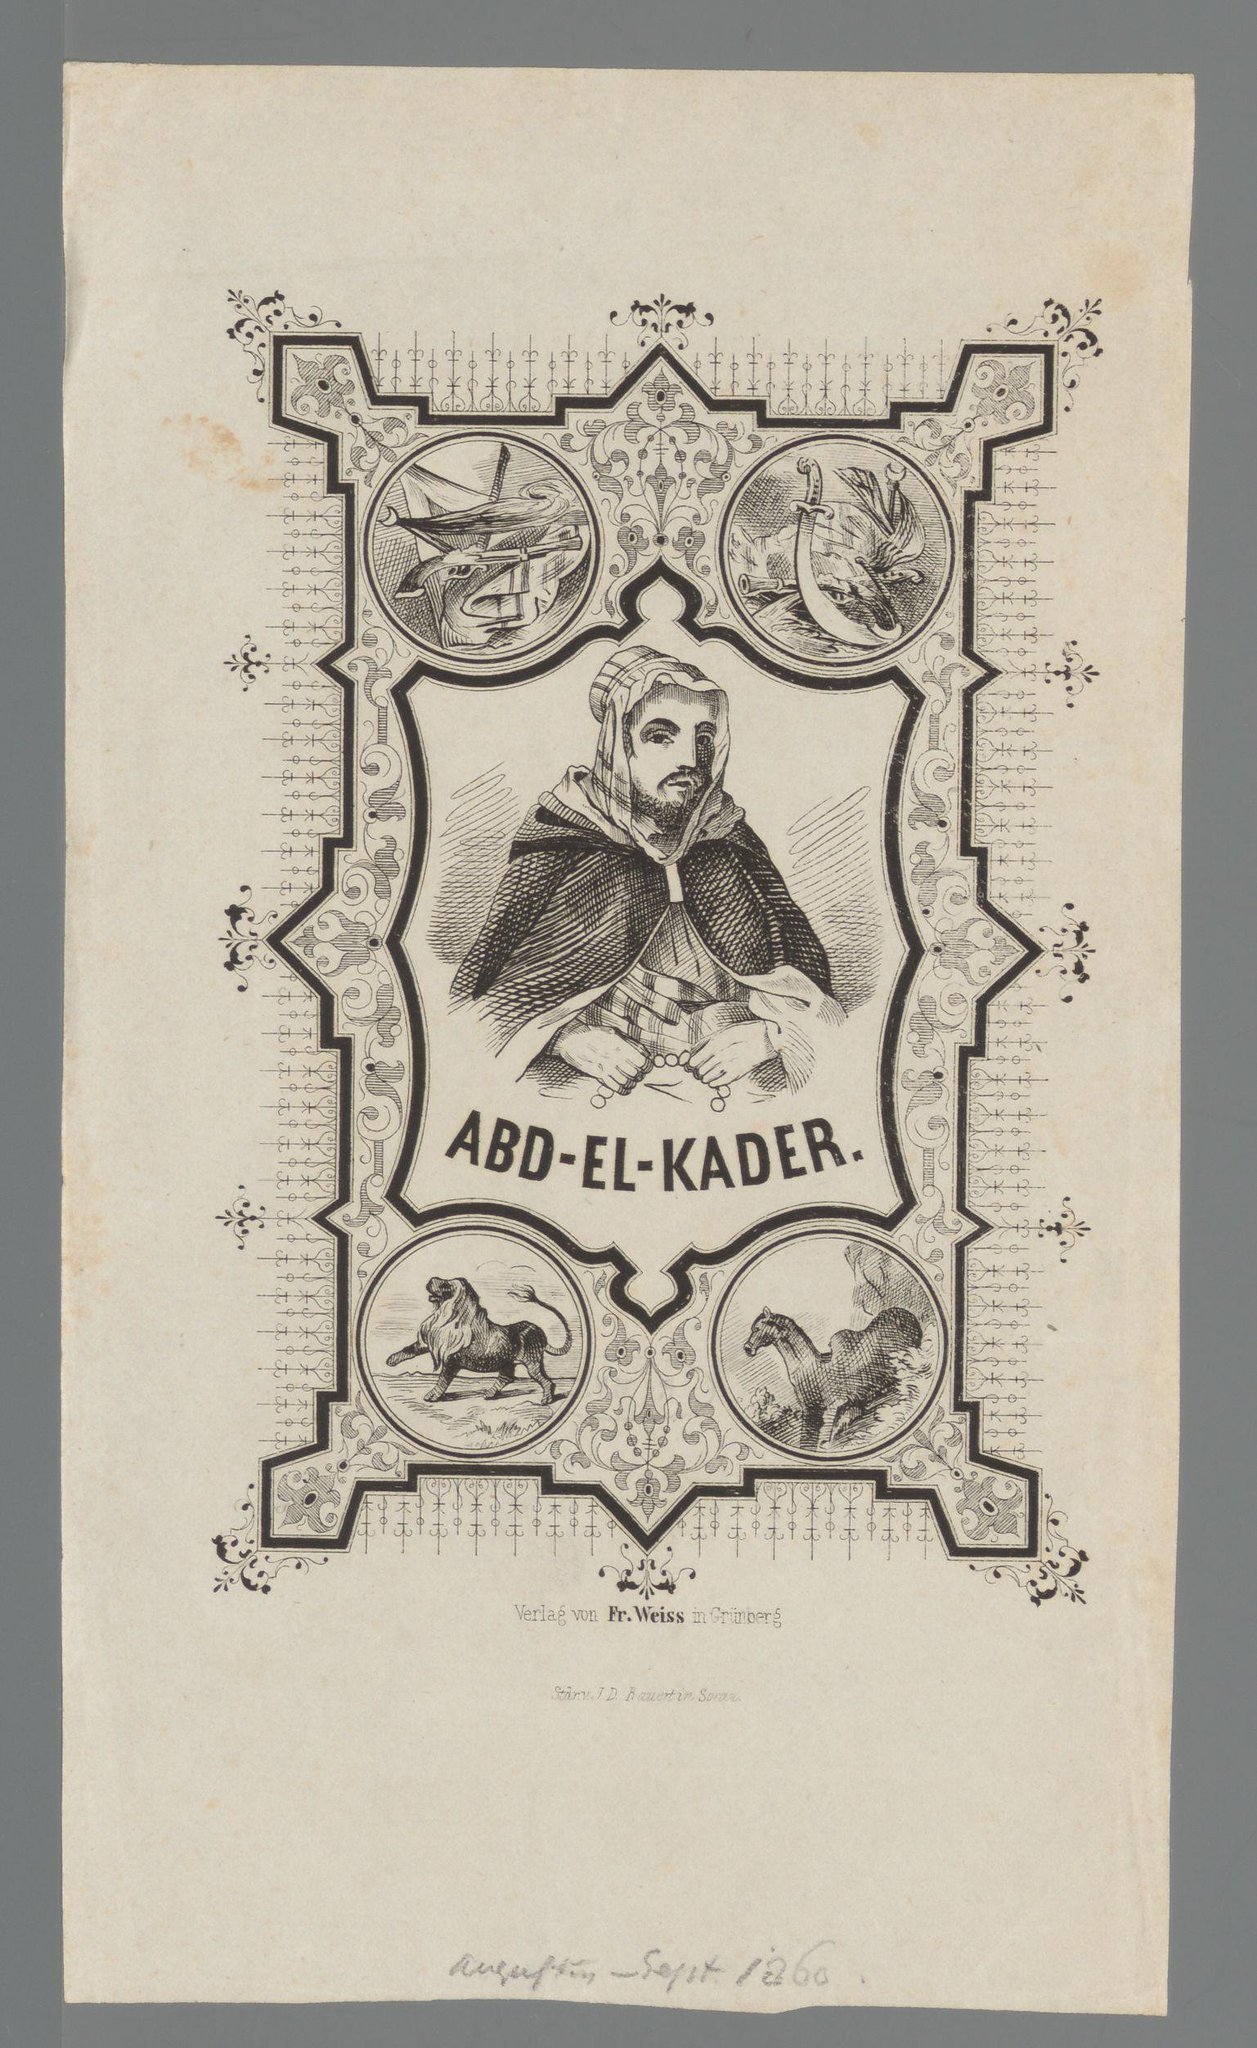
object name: print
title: Portret van Abd al-Kader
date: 1840-1870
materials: paper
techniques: lithograph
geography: grünberg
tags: historical persons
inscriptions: collector's mark: Lugt 2228